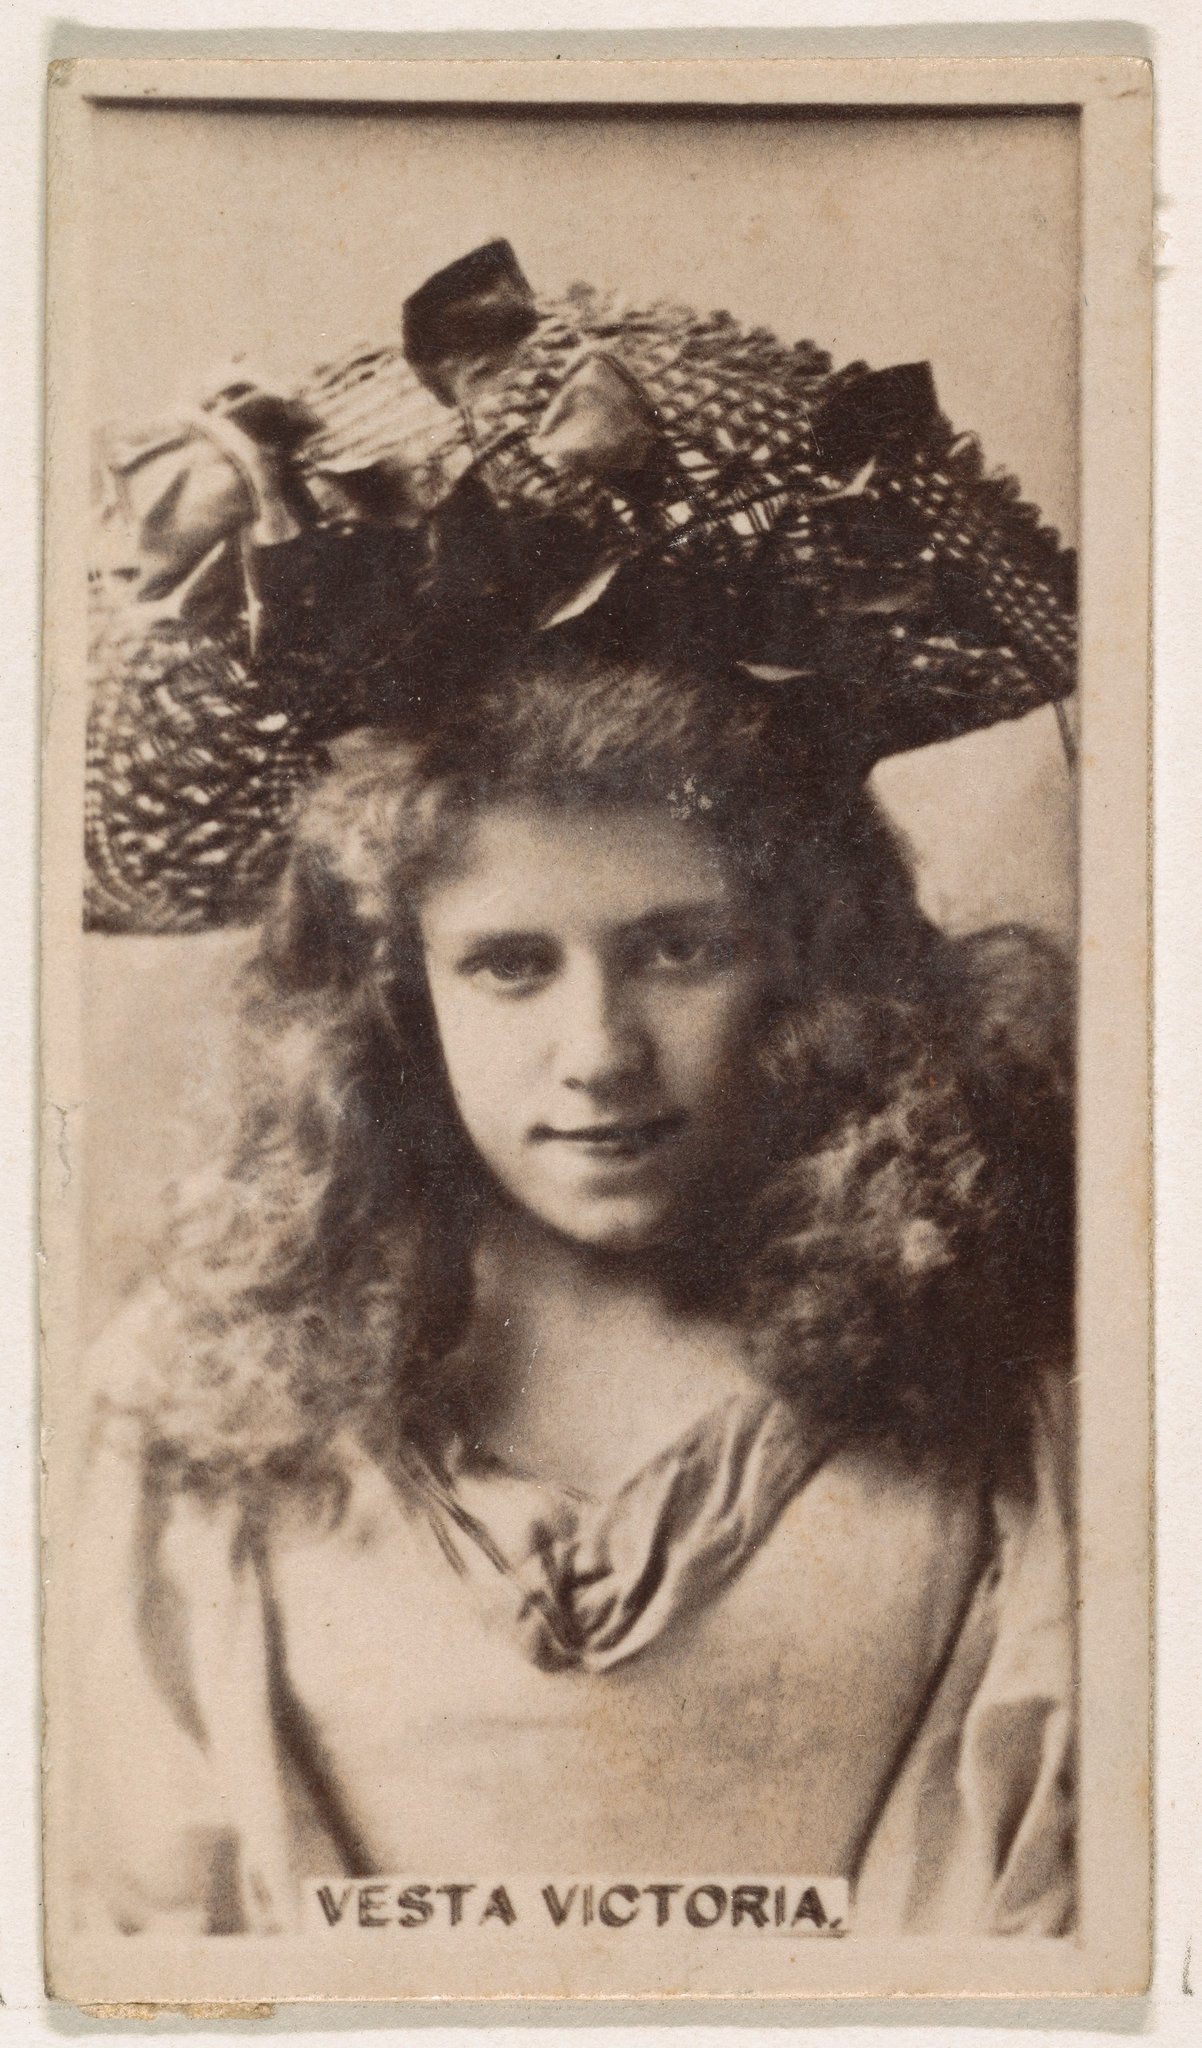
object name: photograph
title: Vesta Victoria, from the Actresses series (N245) issued by Kinney Brothers to promote Sweet Caporal Cigarettes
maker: kinney brothers tobacco company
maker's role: publisher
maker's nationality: american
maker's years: 1869-2011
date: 1890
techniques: albumen silver print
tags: portraits,women,actresses